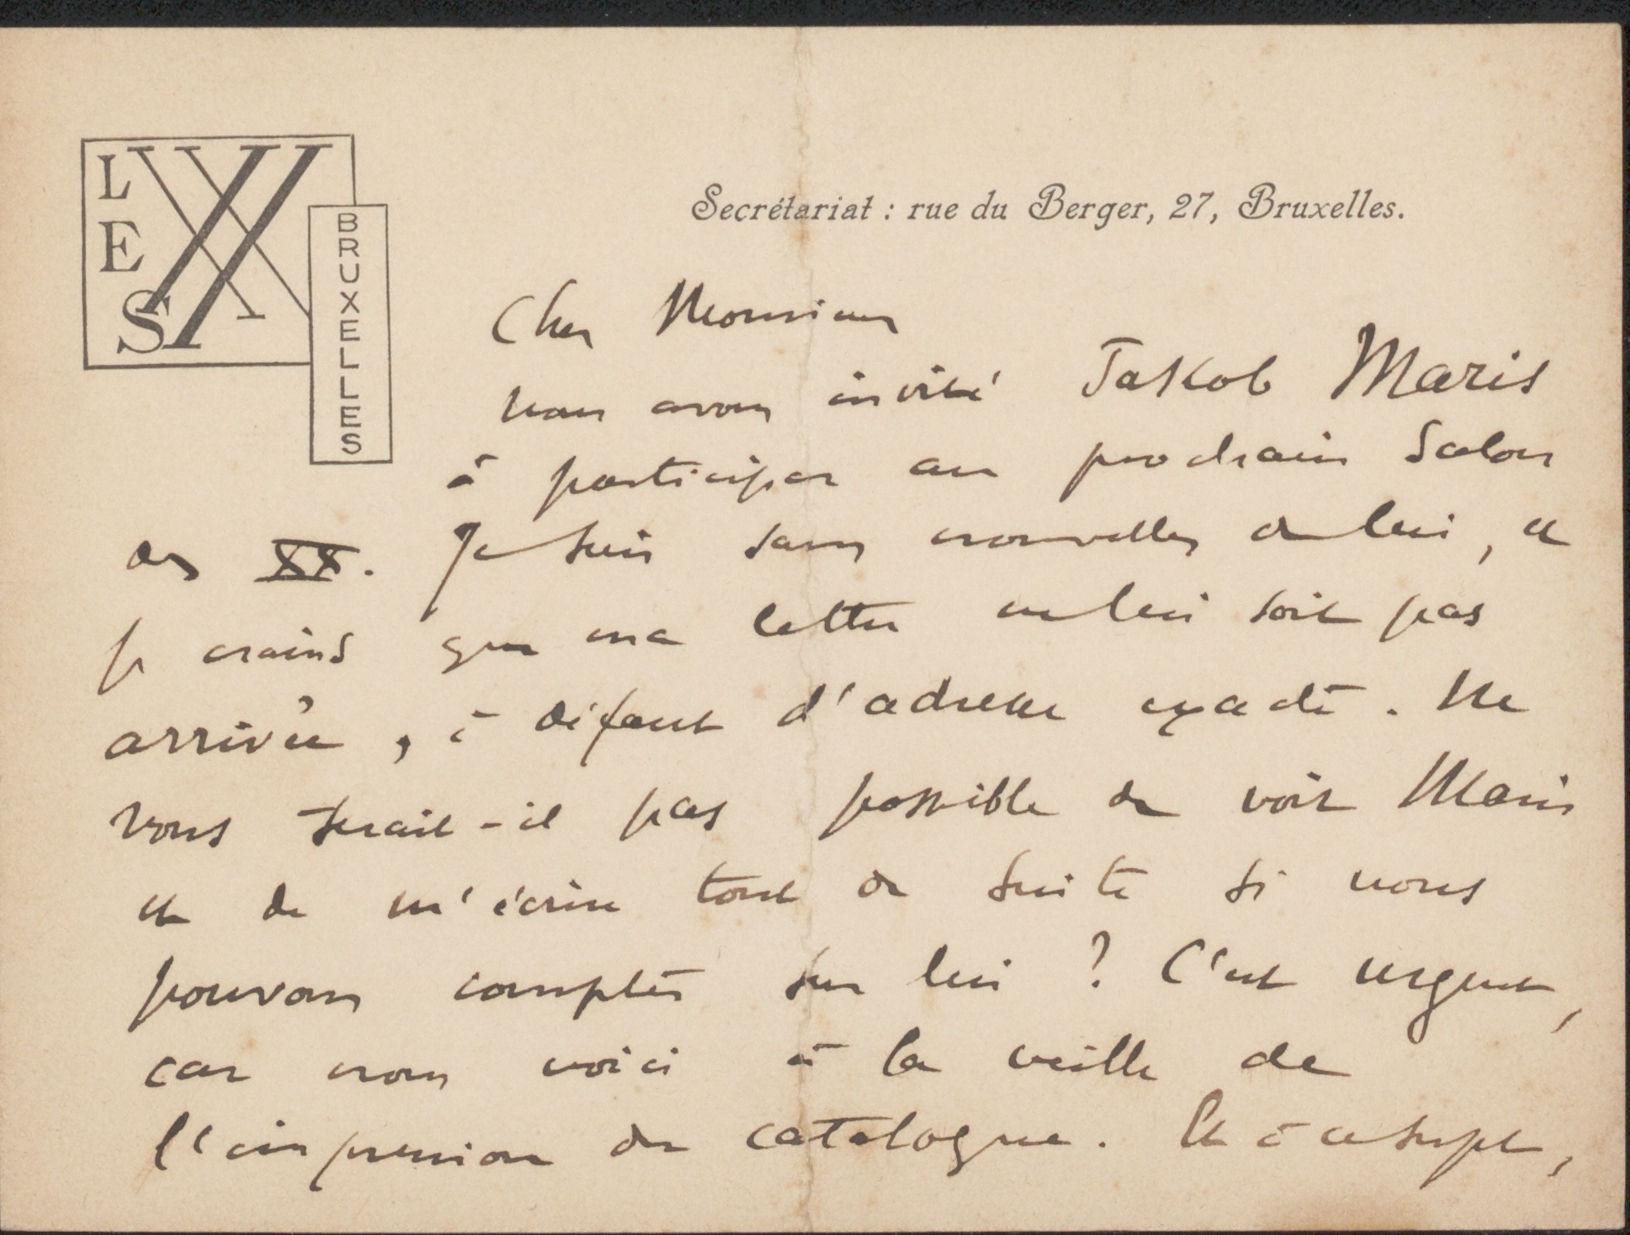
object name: letter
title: Brief aan Philip Zilcken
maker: octave maus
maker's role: painter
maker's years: 1856-1919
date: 1888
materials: cardboard, ink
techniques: pen, printing, writing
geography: brussels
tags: the hague, painter, print maker, draughtsman, jacob maris, philip zilcken, temporary exhibition, 'salon'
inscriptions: collector's mark: ‘RPK’